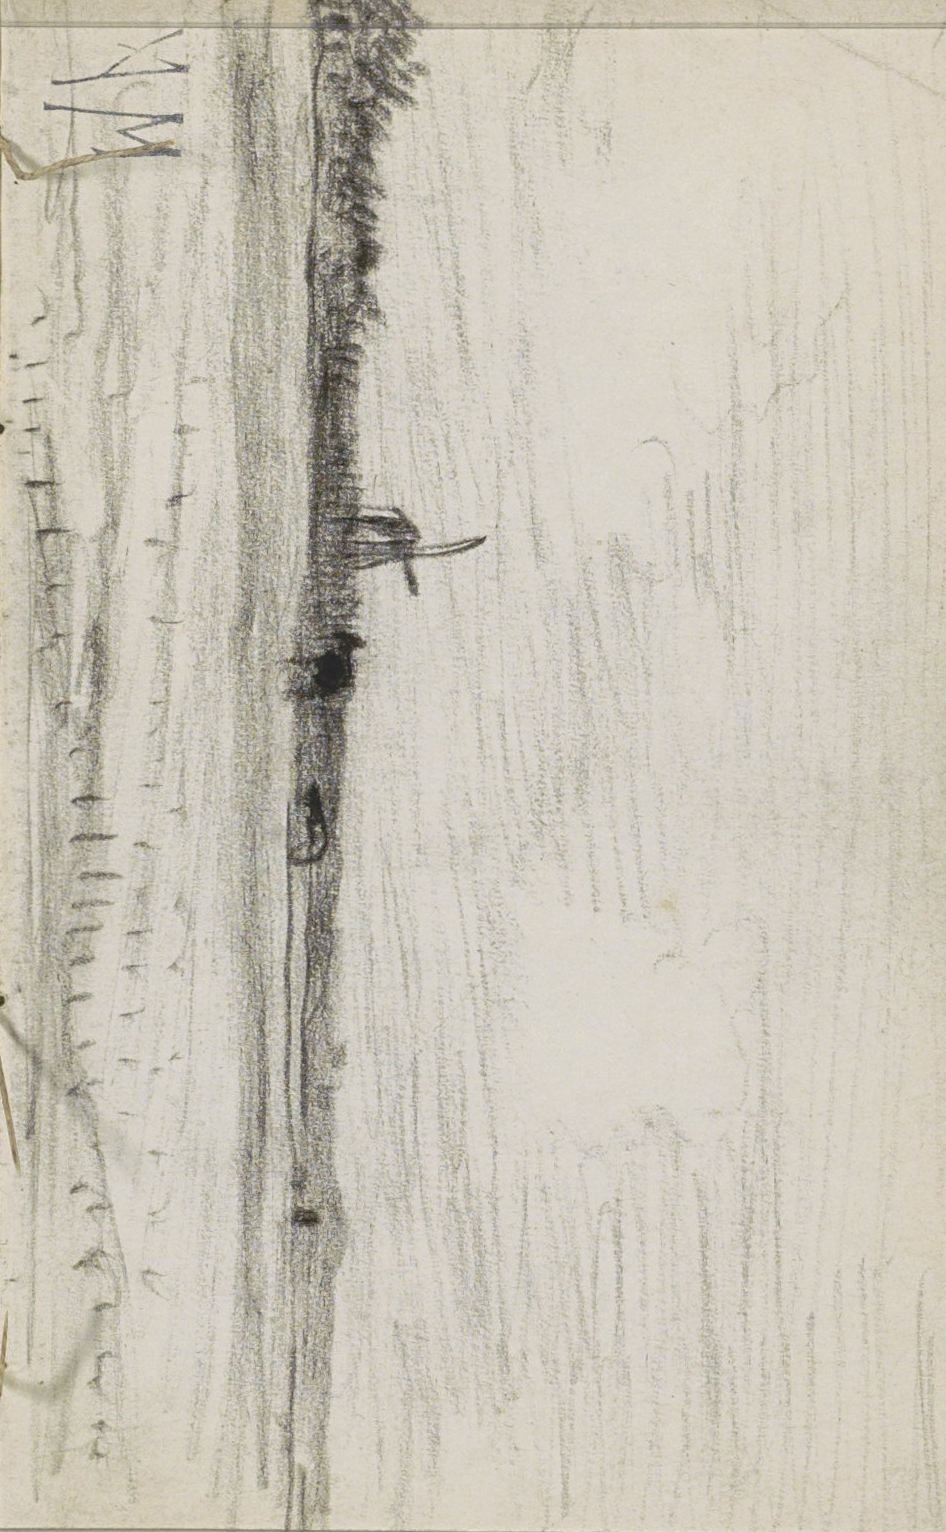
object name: sketchbook leaf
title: Weiland met een molen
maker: anton mauve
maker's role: draughtsman, painter, print maker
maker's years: 1838-1888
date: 1848-1888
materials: chalk, paper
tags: windmill in landscape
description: Blad 10 recto uit een schetsboek met 53 bladen.